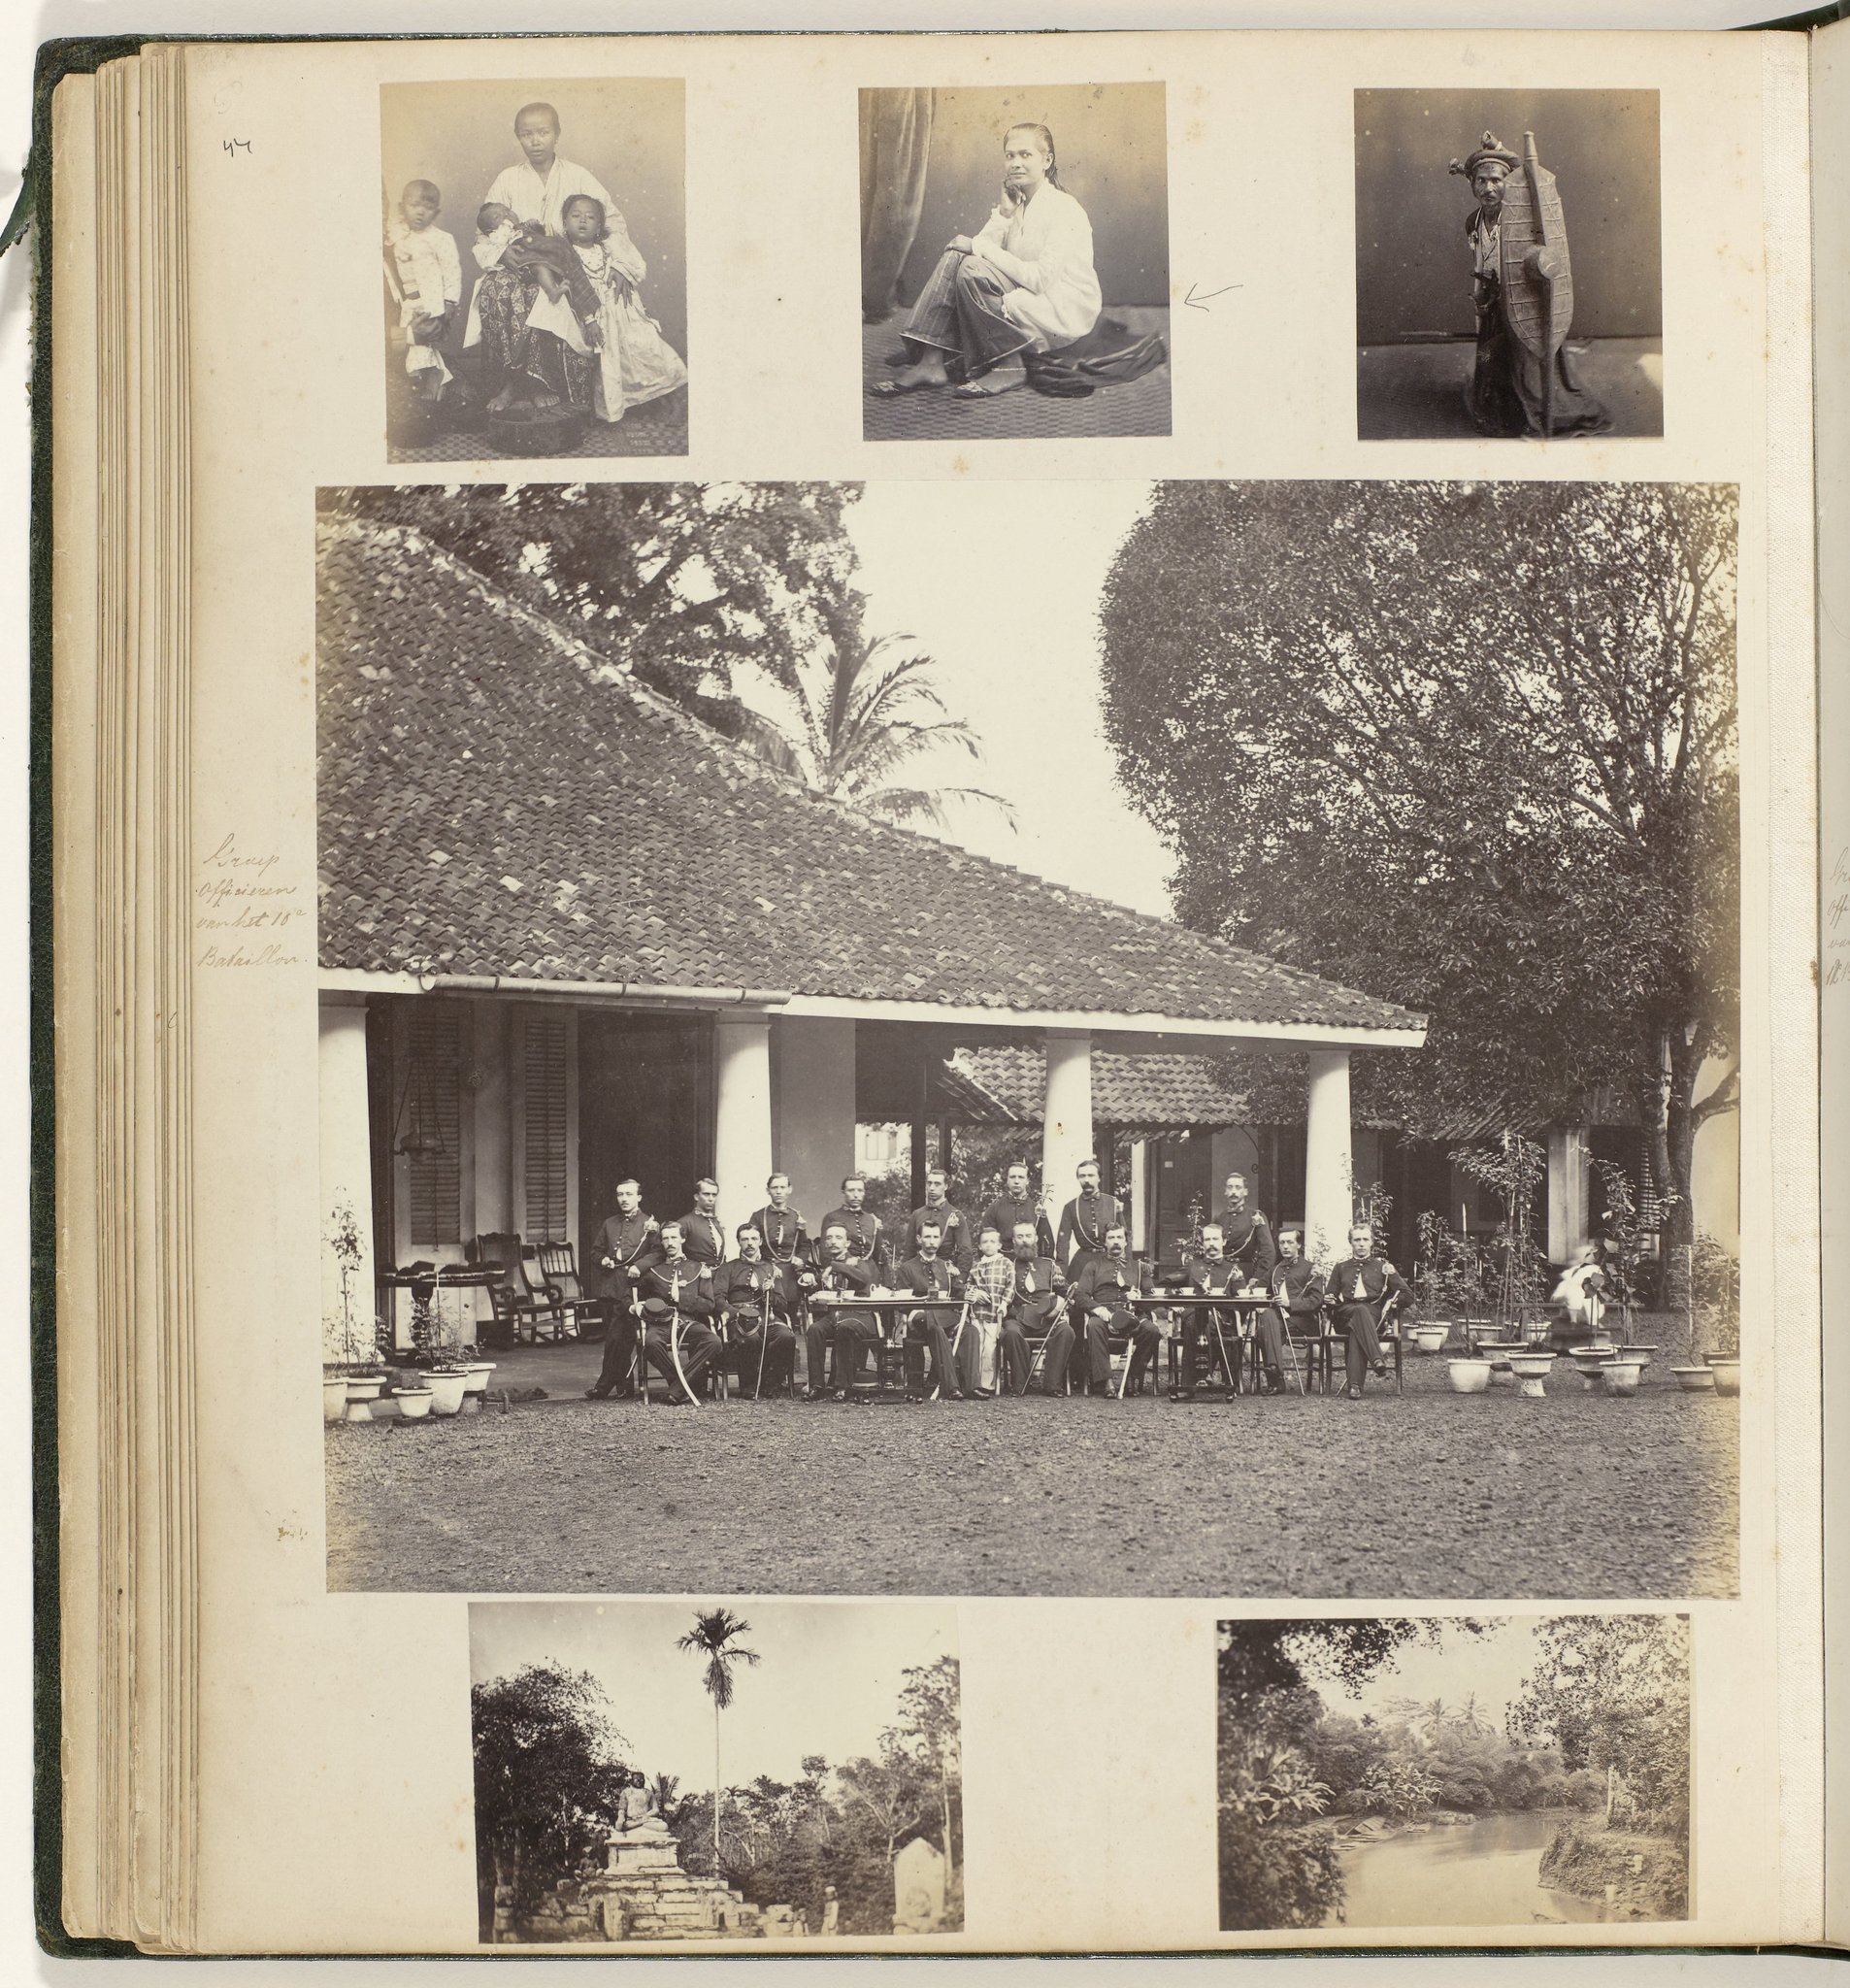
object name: photograph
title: Militairen, portretten en landschap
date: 1863-1866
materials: cardboard, photographic support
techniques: albumen print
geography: batavia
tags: historical persons not known by name - bb - woman, anonymous historical persons portrayed in a group, in a group-portrait, batavia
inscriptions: inscription: ‘Groep officieren van het 10e Bataillon’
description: Albumblad met zes foto's. Centraal een groepsfoto van een groep officieren van het 10e bataljon KNIL, in de tuin van een huis in Batavia. Boven drie studioportretten, onderaan twee landschappen. Onderdeel van het tweede groene fotoalbum met foto's van Java, uit het bezit van apotheker Specht-Grijp, die in 1865 vanuit Batavia naar Nederland terugkeerde.